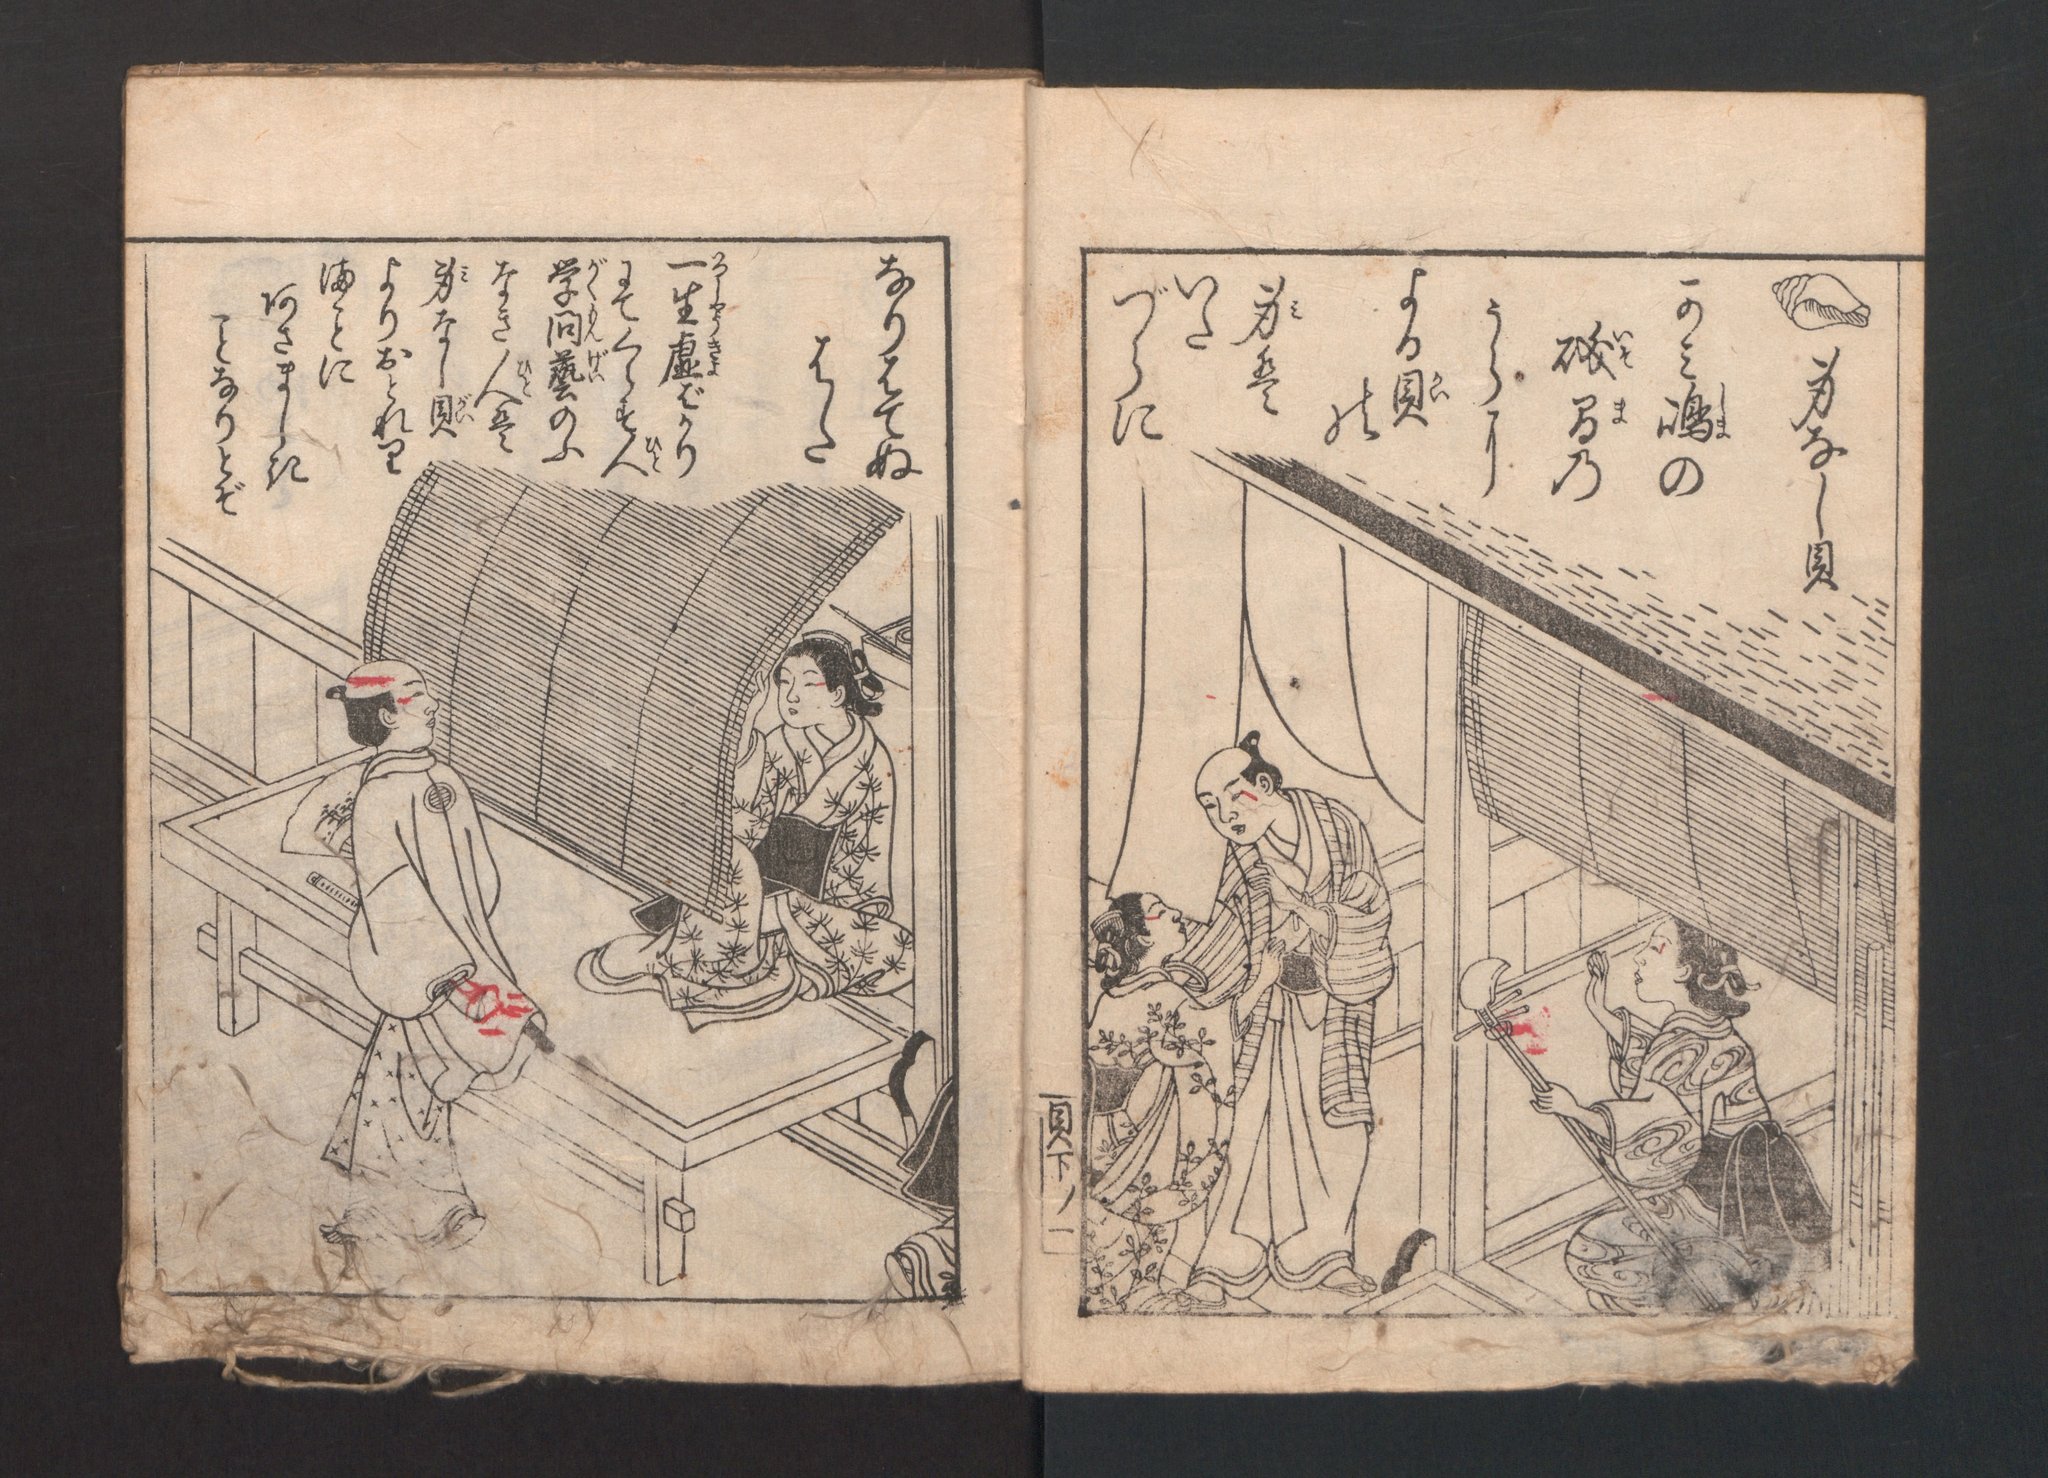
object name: illustrated book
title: Illustrated Poems (Ehon Kaikasen) 絵本貝歌仙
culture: japanese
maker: nishikawa sukenobu 西川祐信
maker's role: artist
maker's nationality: japanese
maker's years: 1671-1750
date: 1747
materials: ink, paper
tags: poetry,men,women